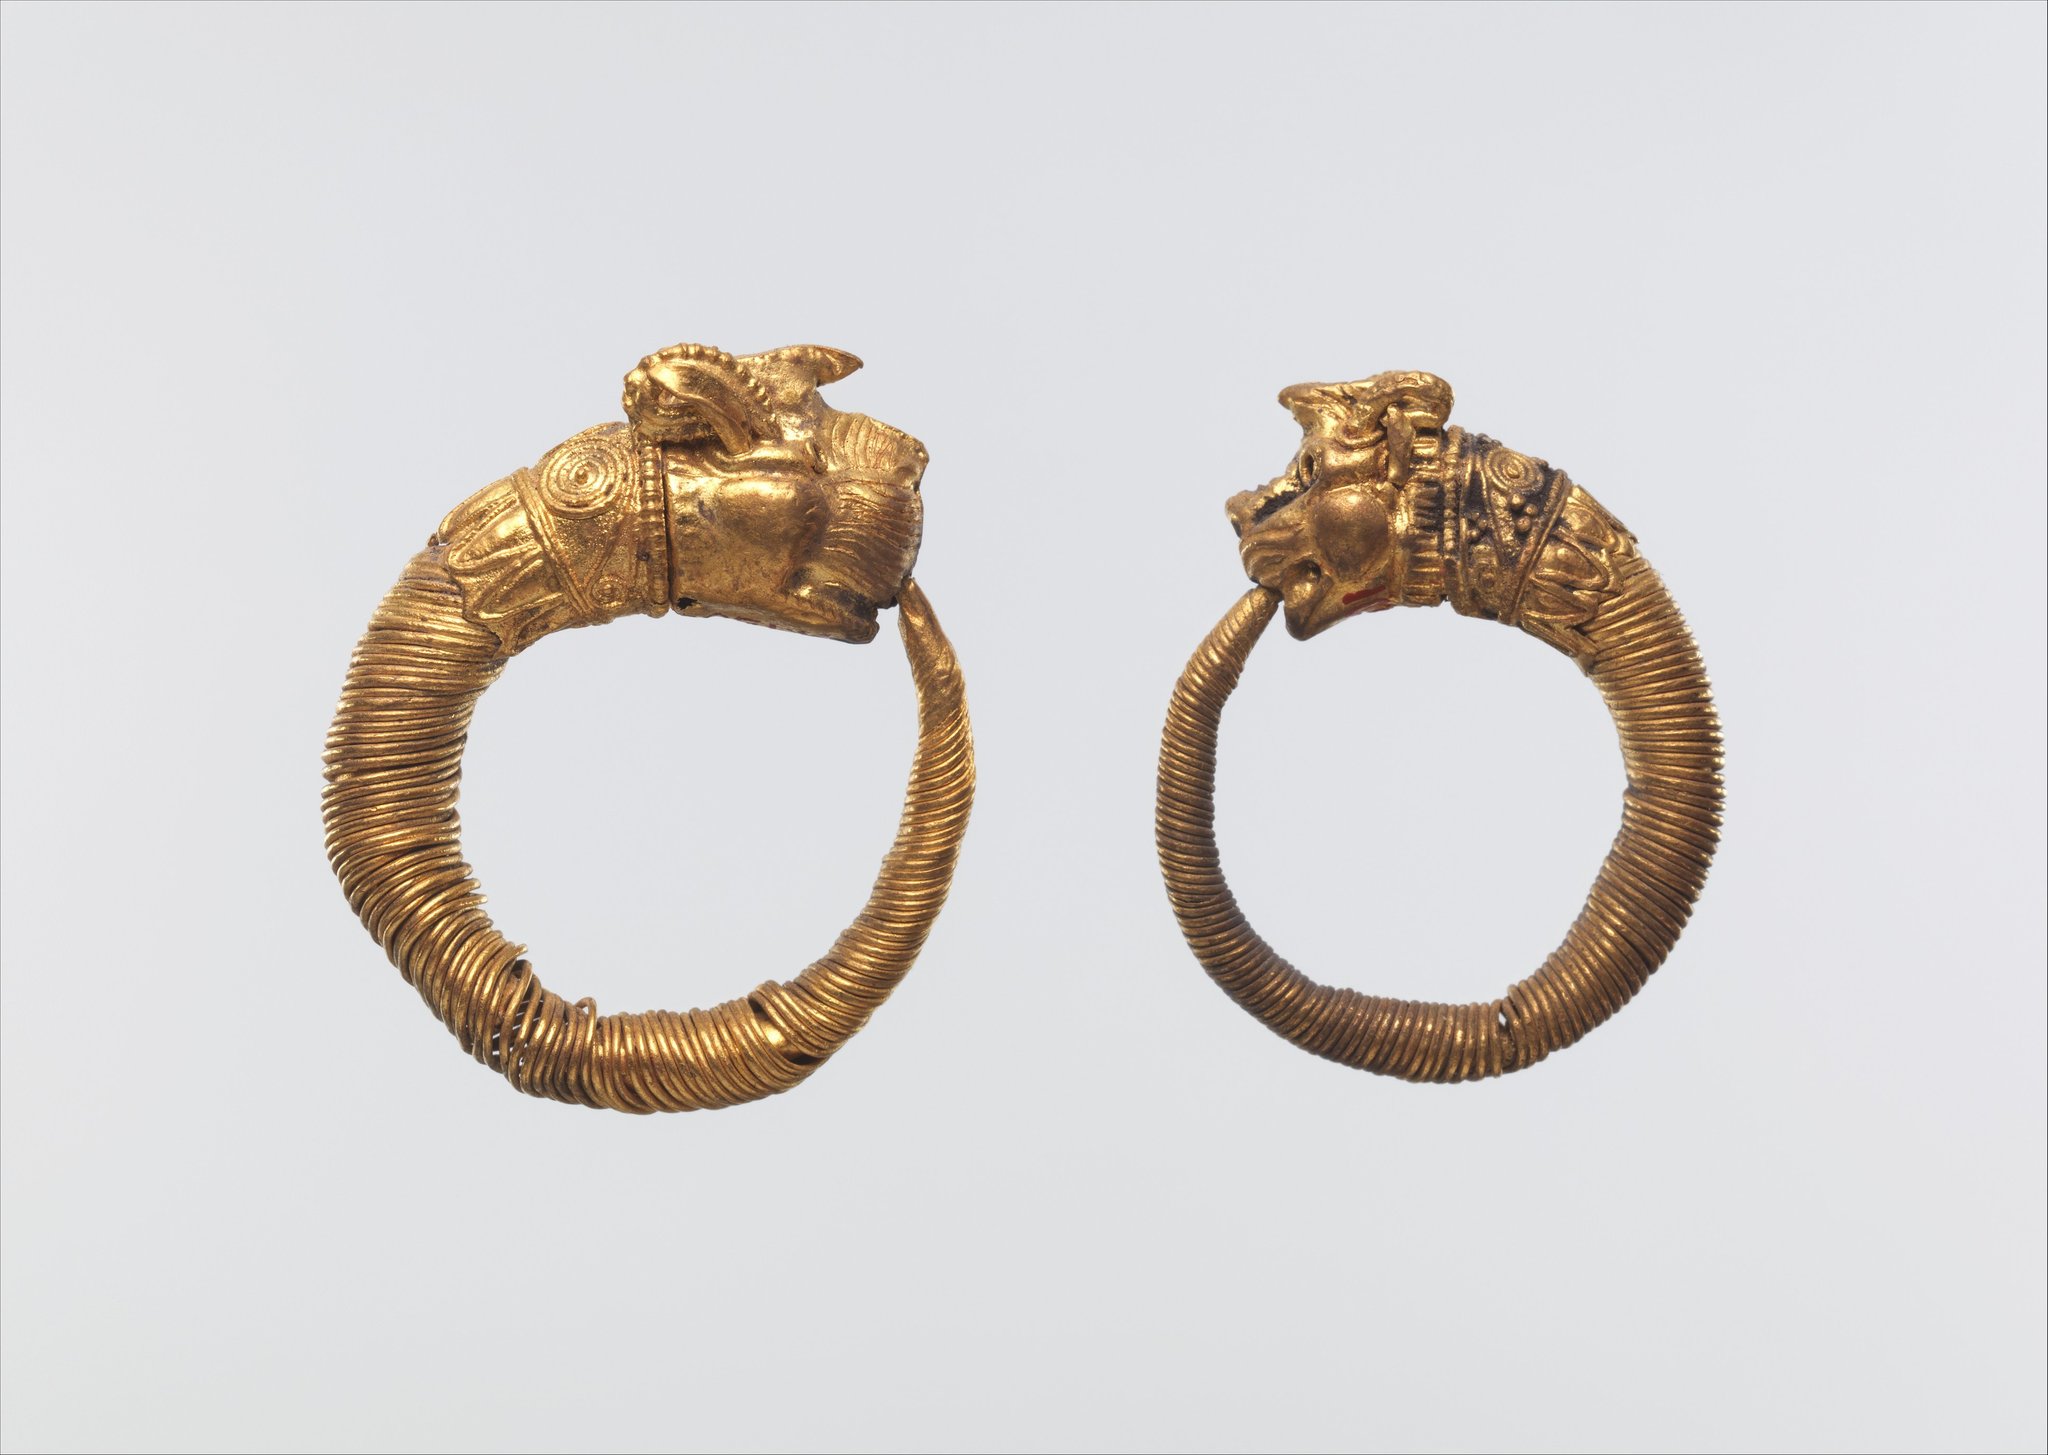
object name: earring, lion griffin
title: Earring with lion-griffin terminal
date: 400-201 BCE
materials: gold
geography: egypt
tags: griffins